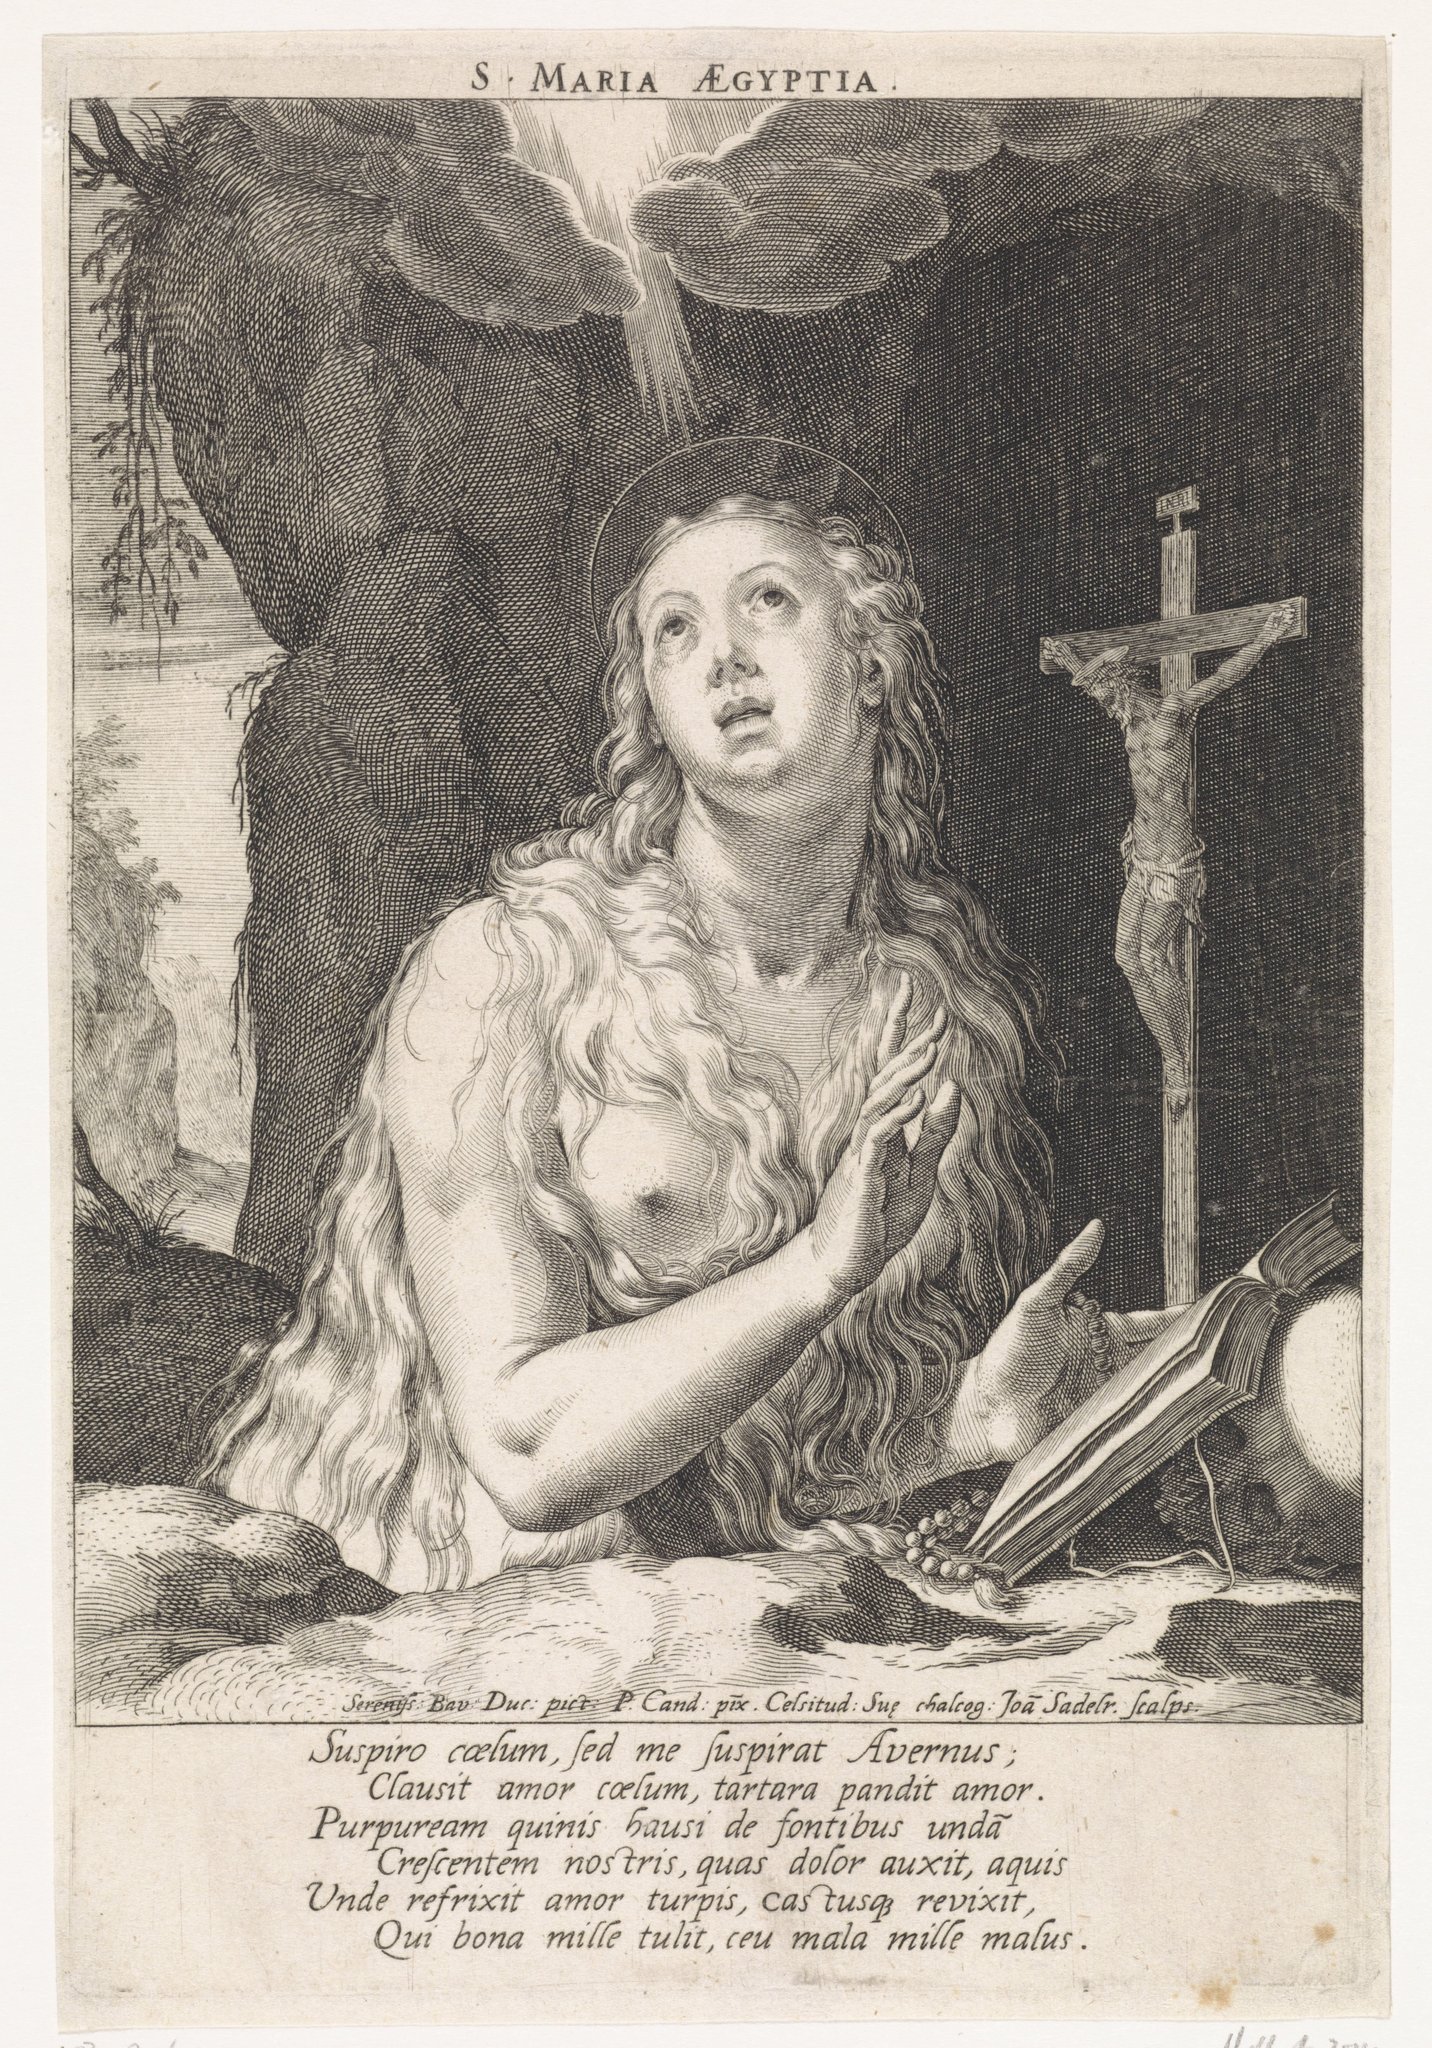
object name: print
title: Heilige Maria van Egypte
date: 1588-1595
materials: paper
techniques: engraving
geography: munich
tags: the penitent harlot mary of egypt (maria aegyptiaca); possible attributes: long hair, three loaves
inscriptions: collector's mark: Lugt 240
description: De H. Maria van Egypte zittend in een grot. Rechts een crucifix, een boek en een doodshoofd.